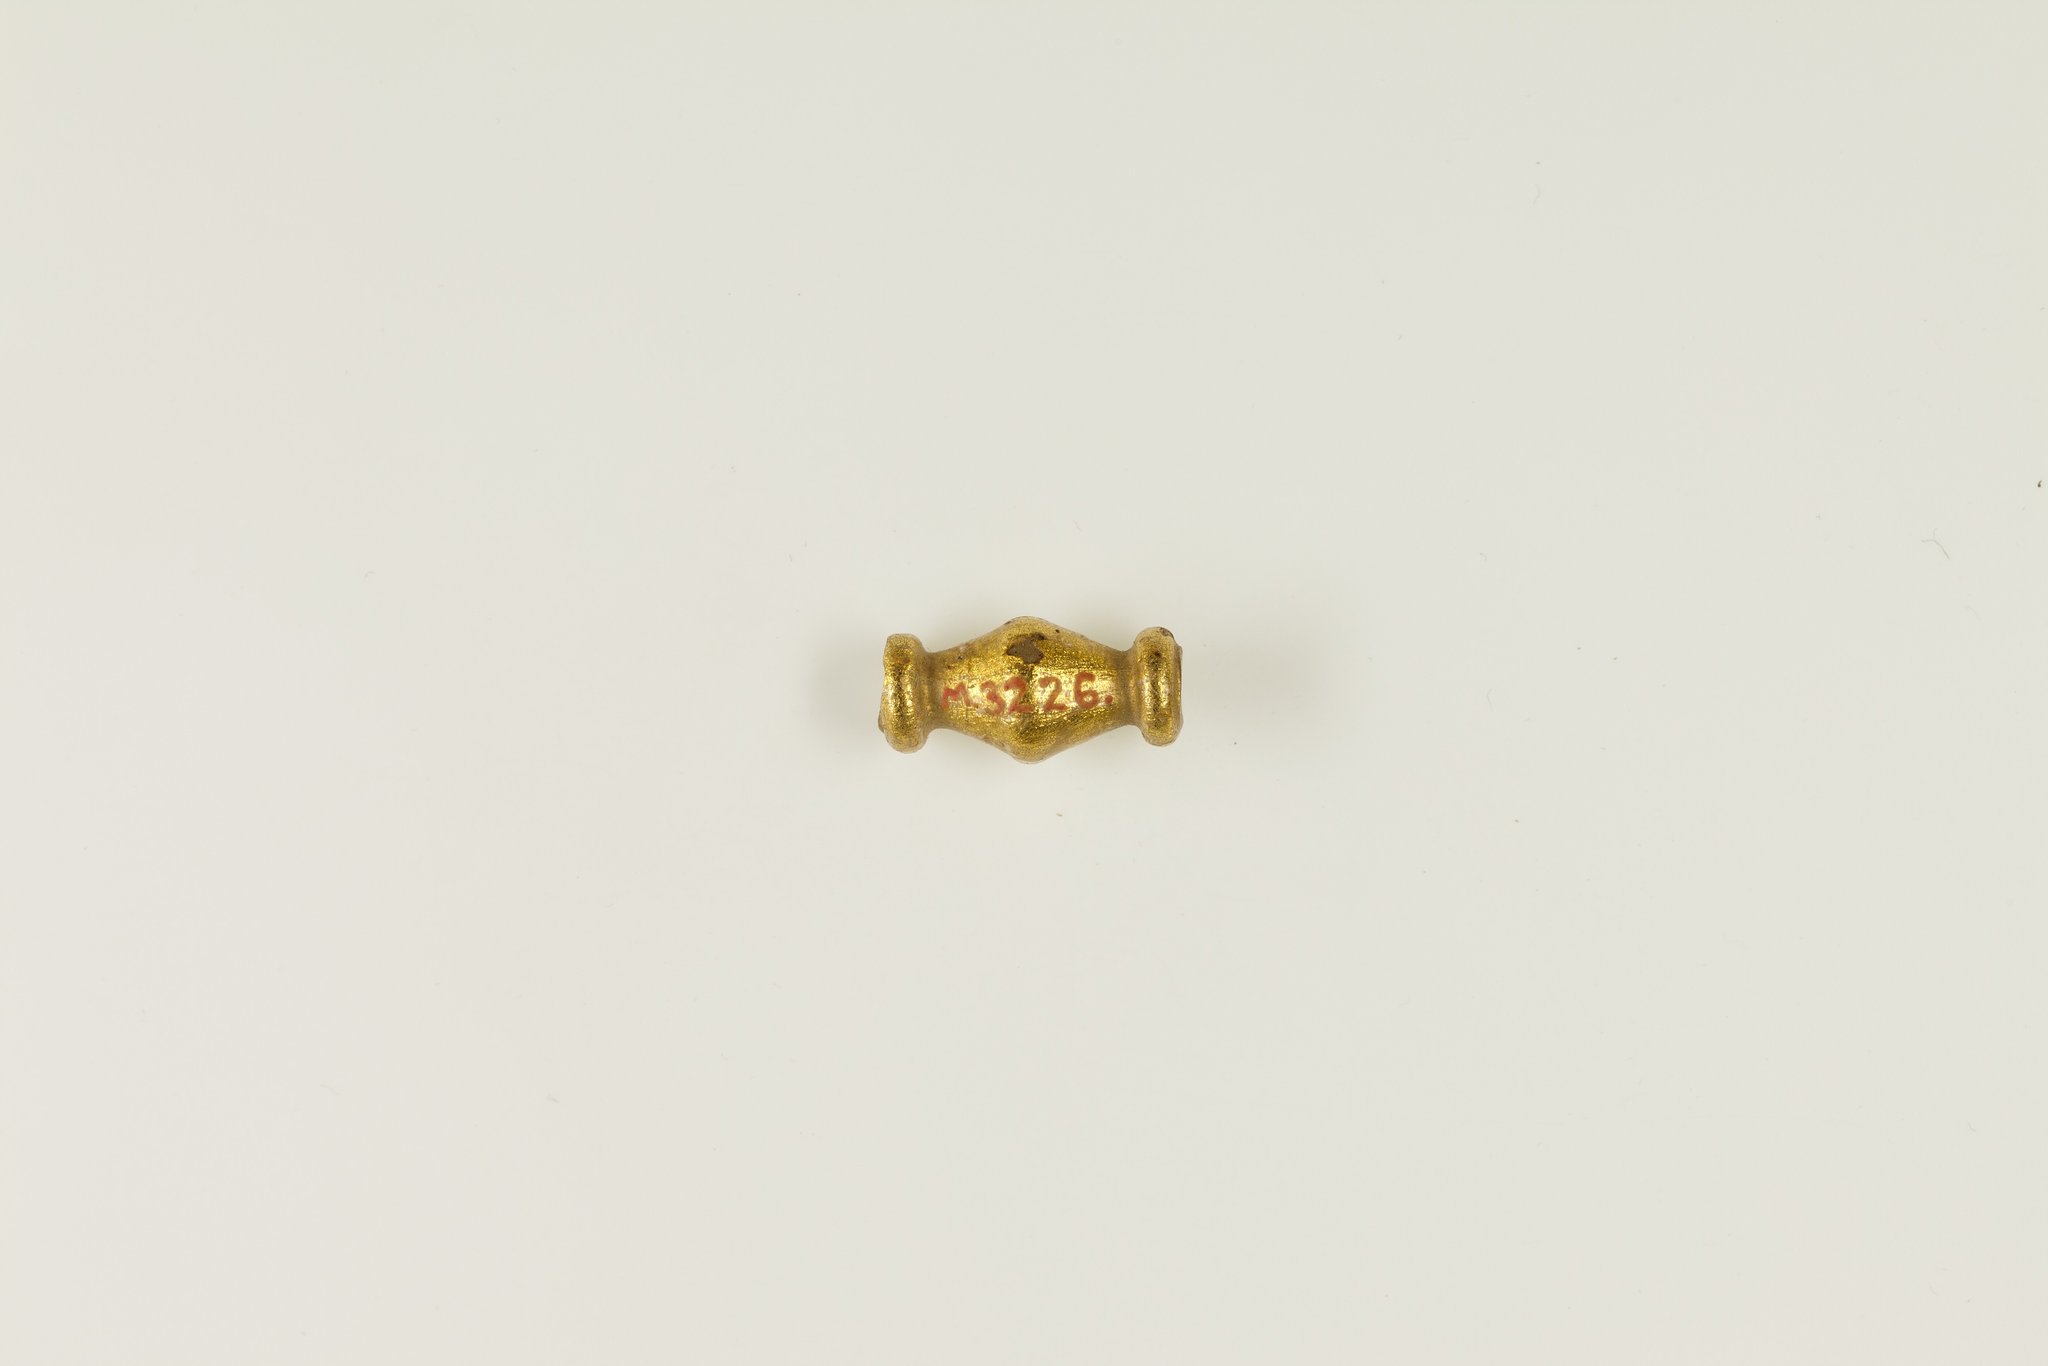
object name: bead, flattened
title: Spool-shaped bead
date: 100 BCE-200 CE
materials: glass, gold foil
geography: egypt